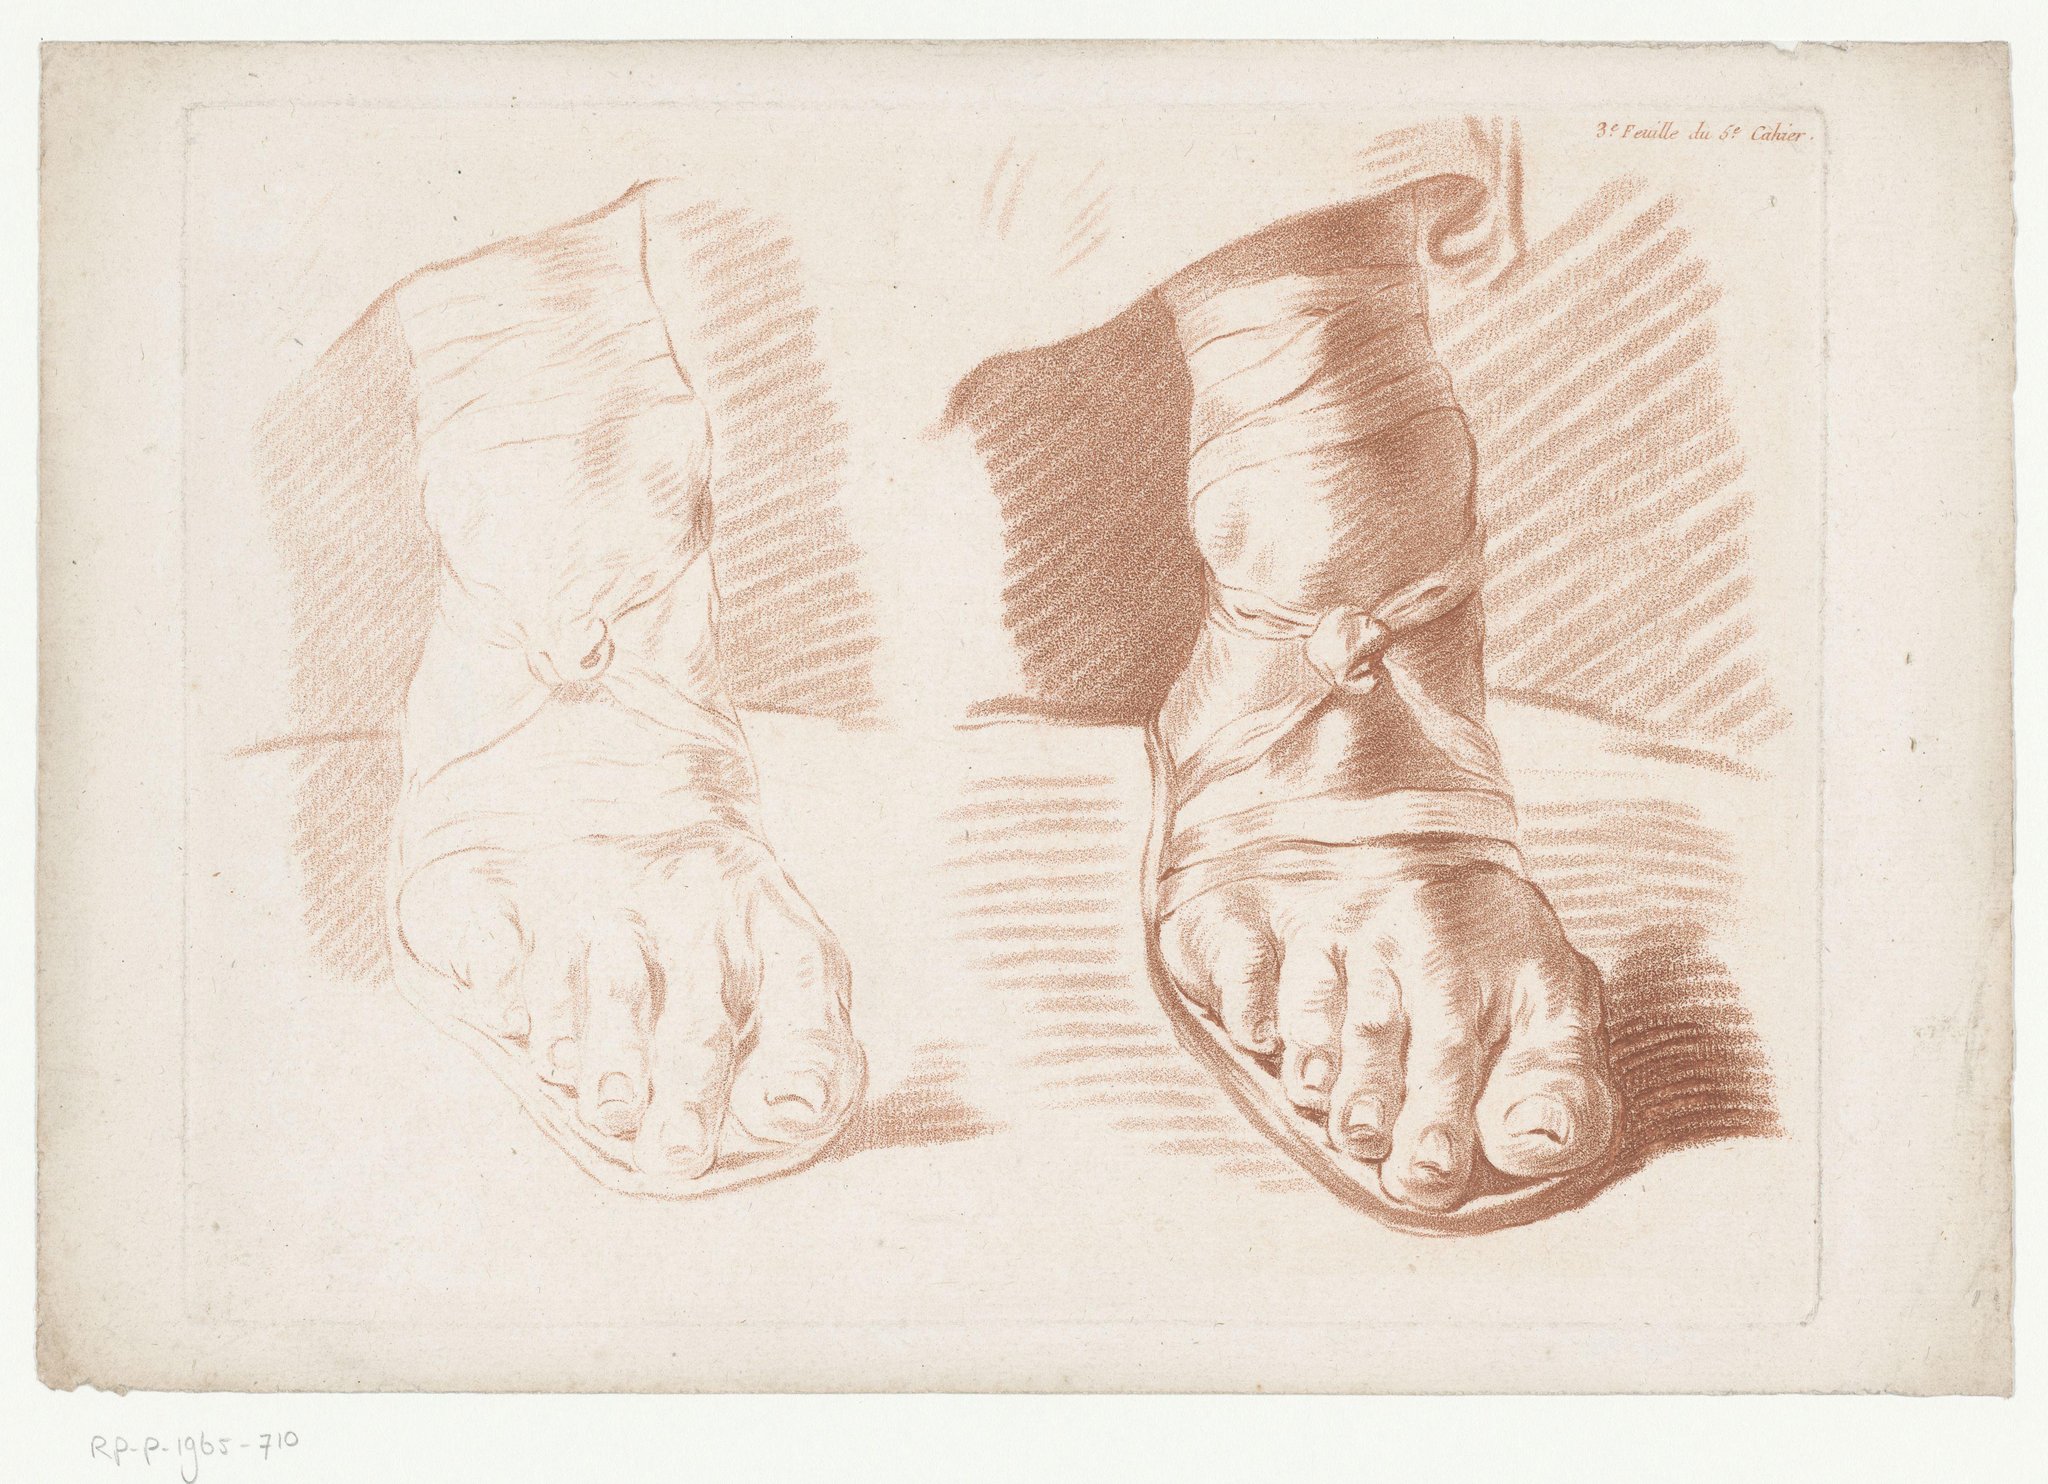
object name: print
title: Twee voeten in sandalen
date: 1773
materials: paper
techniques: printmaking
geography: paris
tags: foot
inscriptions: collector's mark: Lugt 2228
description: Deze prent maakt deel uit van een album dat uit minstens elf delen bestaat. Dit is het derde blad uit het vijfde album. Waarschijnlijk dienden deze albums als voorbeeld voor tekenaars, schilders en graveurs.